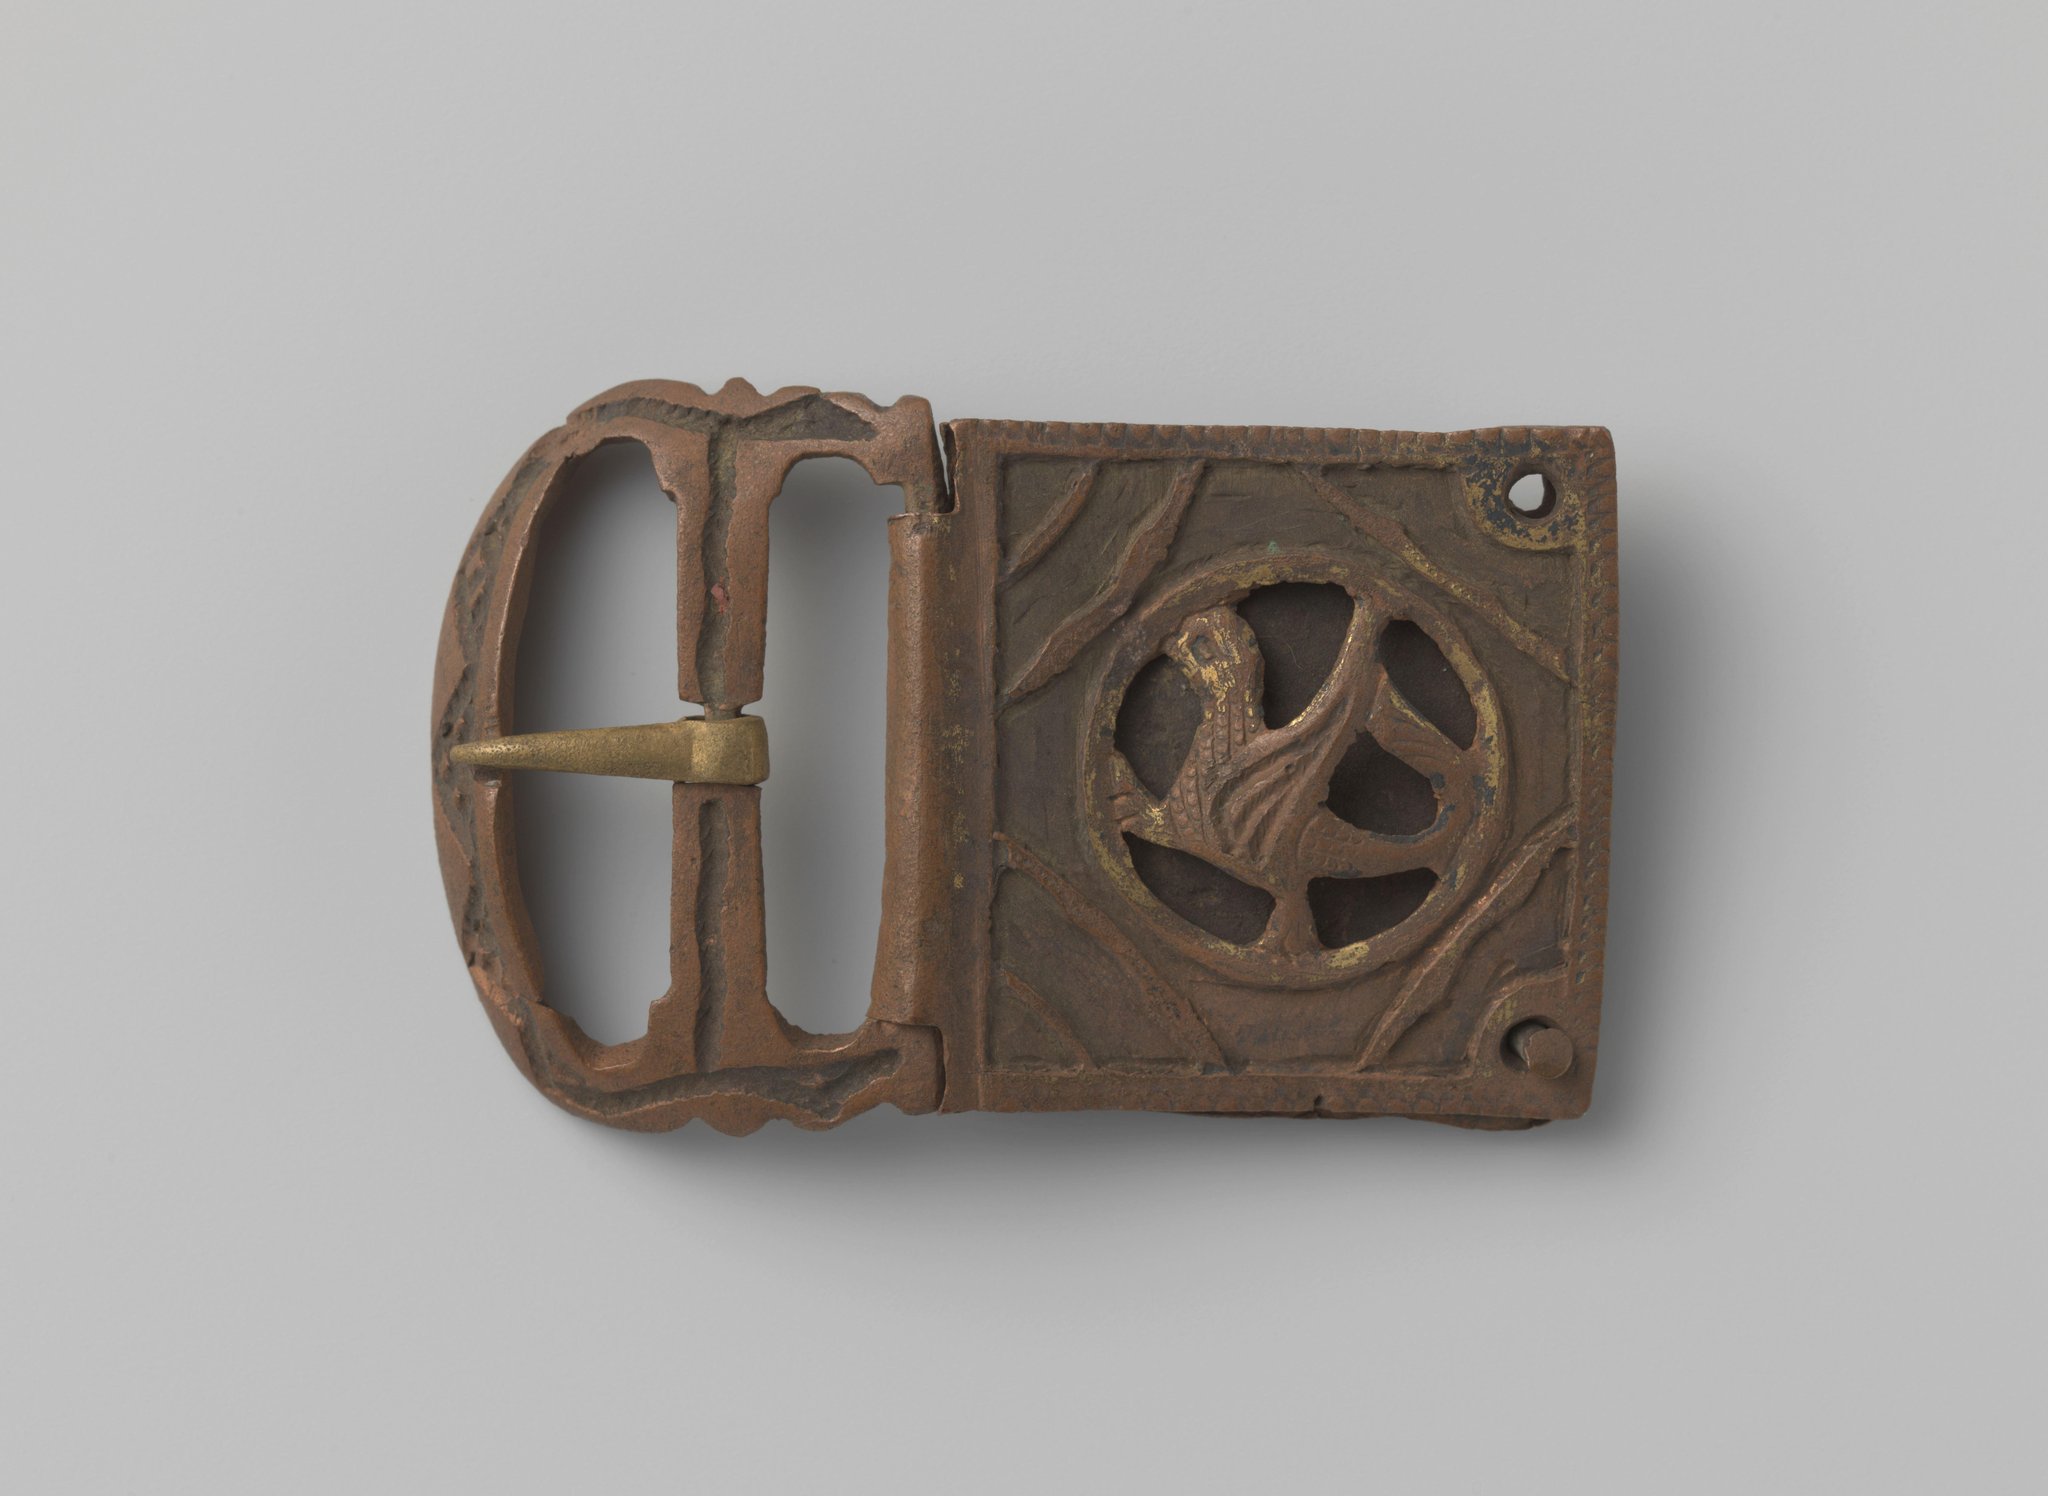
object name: buckle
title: Gesp met griffioen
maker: Anonymous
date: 1100-1200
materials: copper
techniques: casting, cutting, riveted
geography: meuse area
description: Het uit koperplaat gemaakte voorwerp bestaat uit drie delen: het riemstuk, de gesp en de pin. Het vierkante riemstuk heeft een rond middendeel, waarin een griffioen is uitgezaagd. Het omringende veld heeft verdiepte stroken, die vermoedelijk met email waren gevuld. De erstussen gelegen randjes zijn fijn geponst. De achterkant van het riemstuk bestaat uit een dunne plaat, die één geheel vormt met het voorstuk en die zodanig is omgeslagen, dat de gesp eraan is vastgemaakt, en dat er tussen de riem met twee nagels kan worden geklonken. De gesp heeft twee uitgezaagde verticale openingen. De randen hebben een gegroefde versiering, die vermoedelijk met email was gevuld. De pin is niet oorspronkelijk. Een der klinknagels ontbreekt.